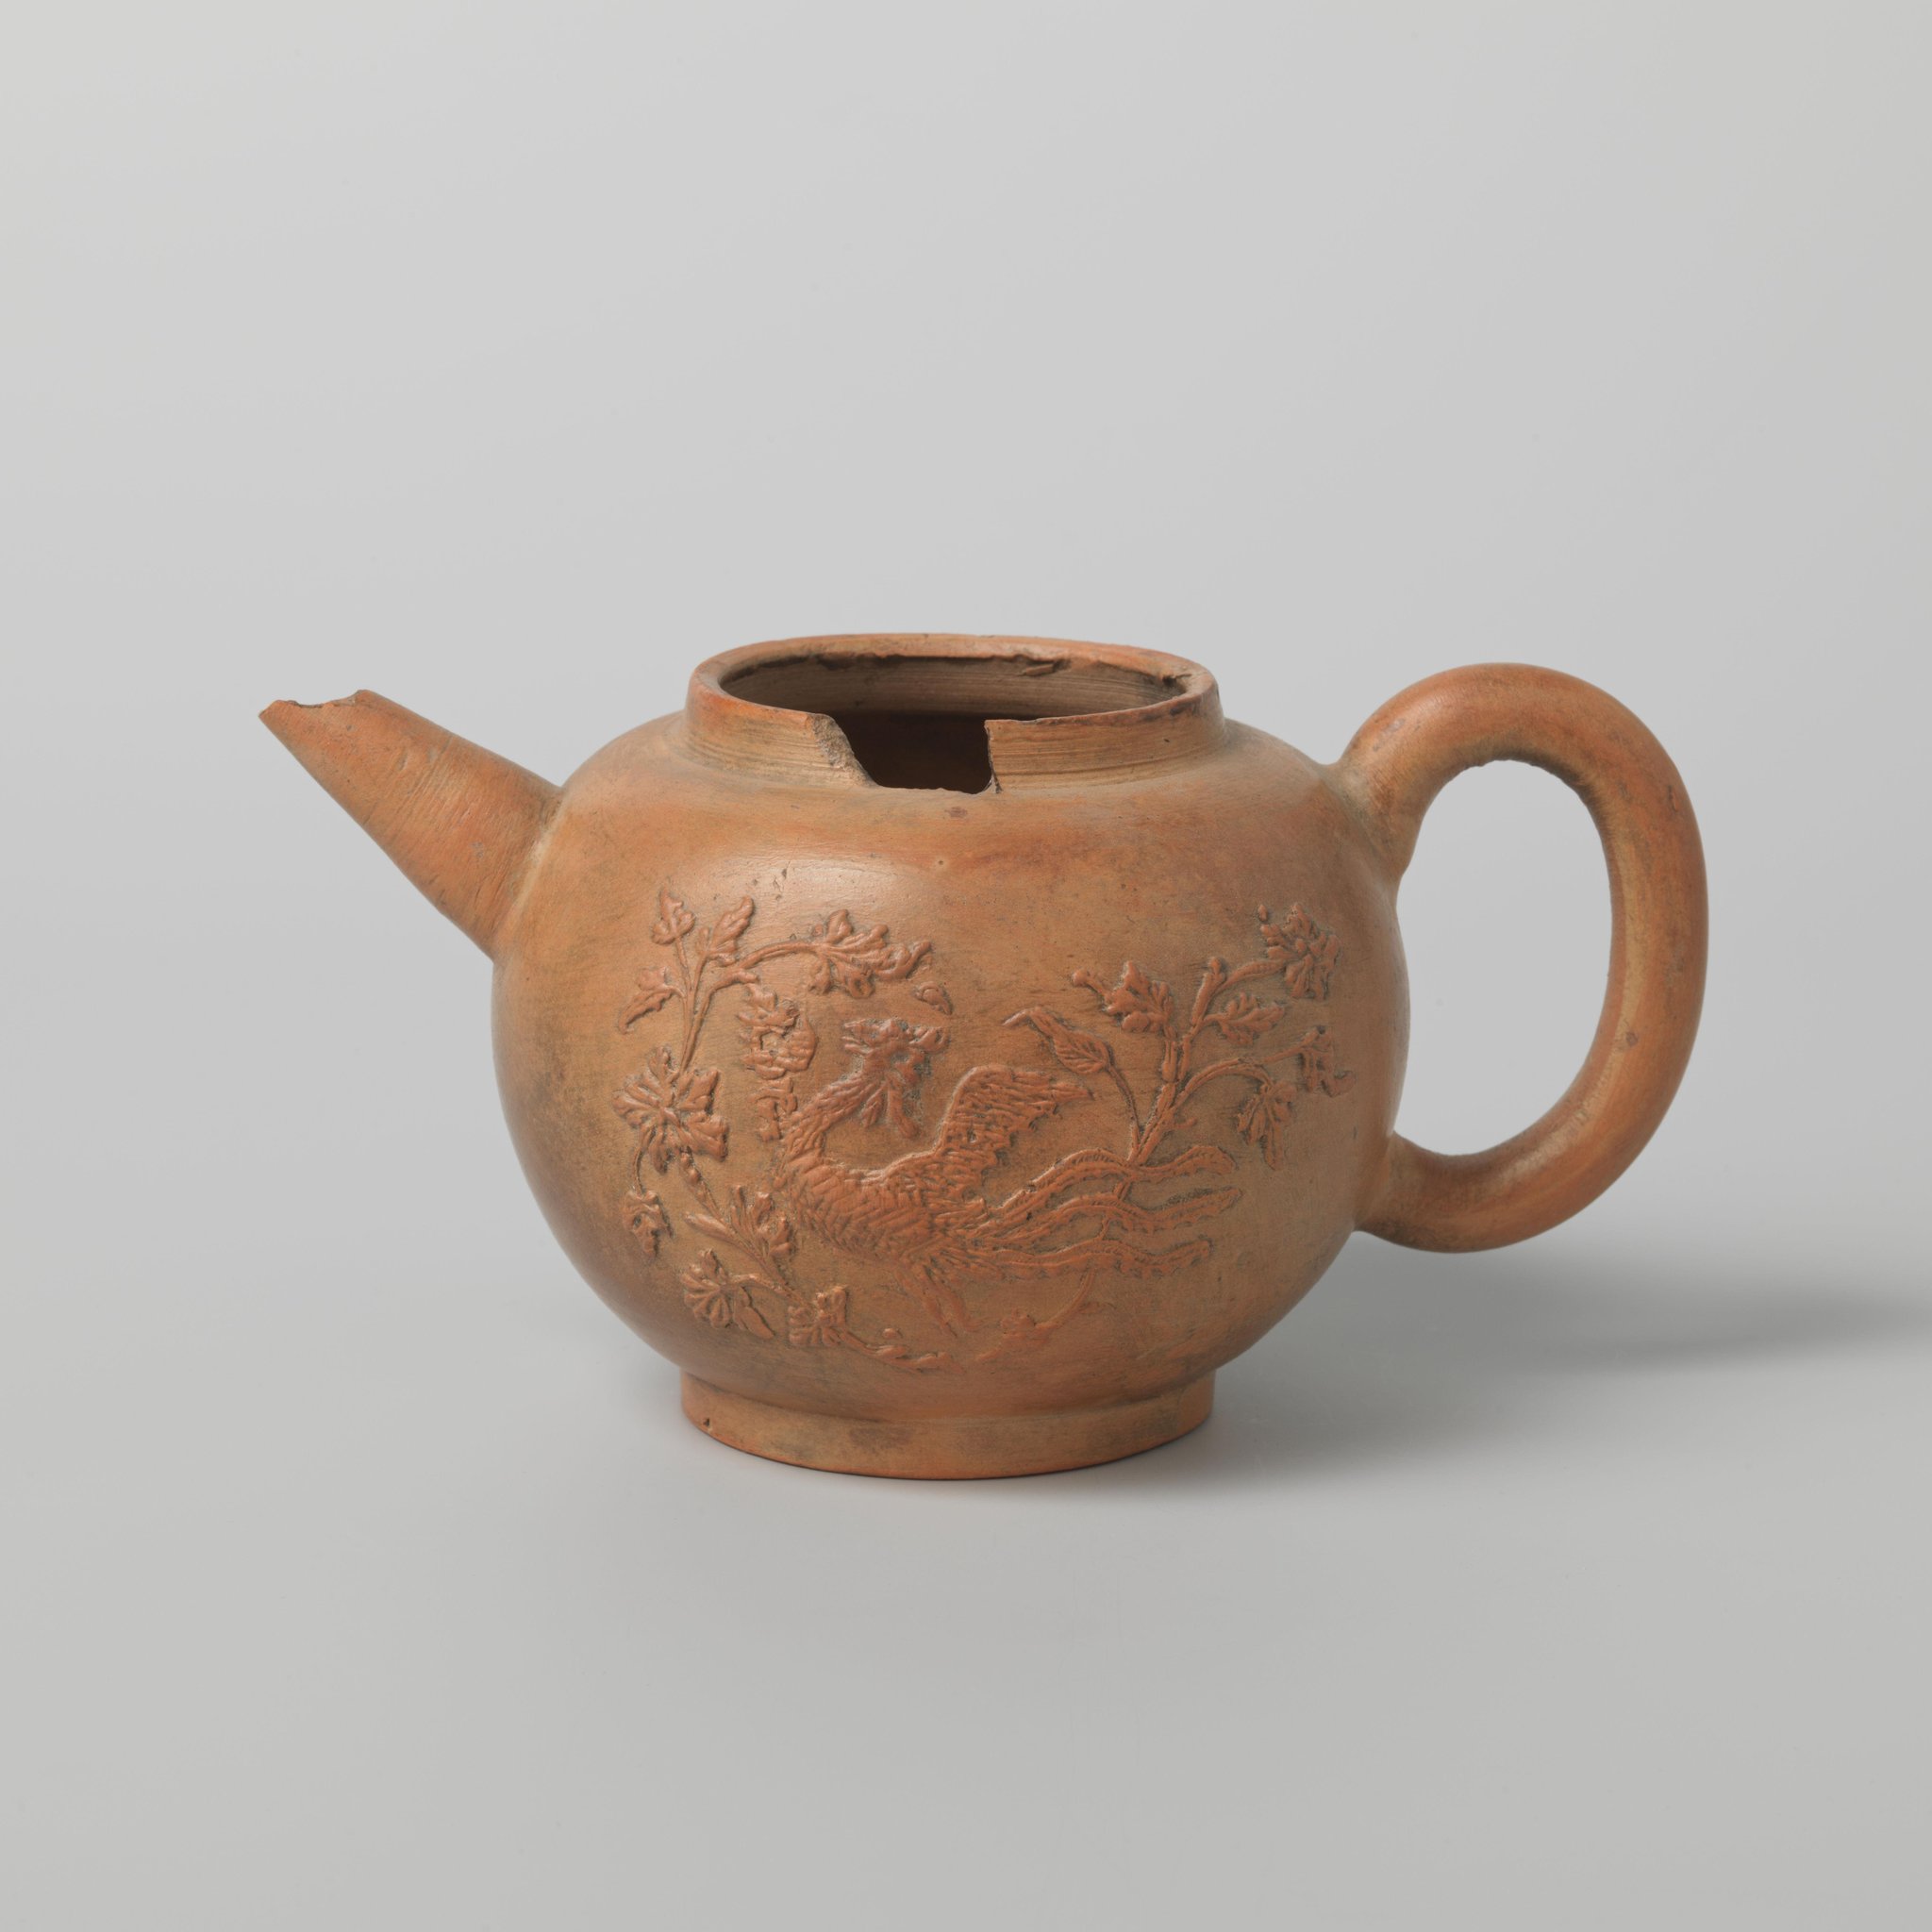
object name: teapot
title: An Excavation Full of Teapots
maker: jacobus de caluwe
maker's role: plateelbakkerij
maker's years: -1730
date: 1700-1725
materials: earthenware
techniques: firing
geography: delft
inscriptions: mark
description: In the early 18th century, the Delft potter Jacobus de Caluwe experimented with innovative forms of teapots based on examples from Yixing. These teapots were excavated at the very site where De Caluwe had his factory. They exhibit a wide variety, ranging from traditional red stoneware items to new creations with glaze in different colours.